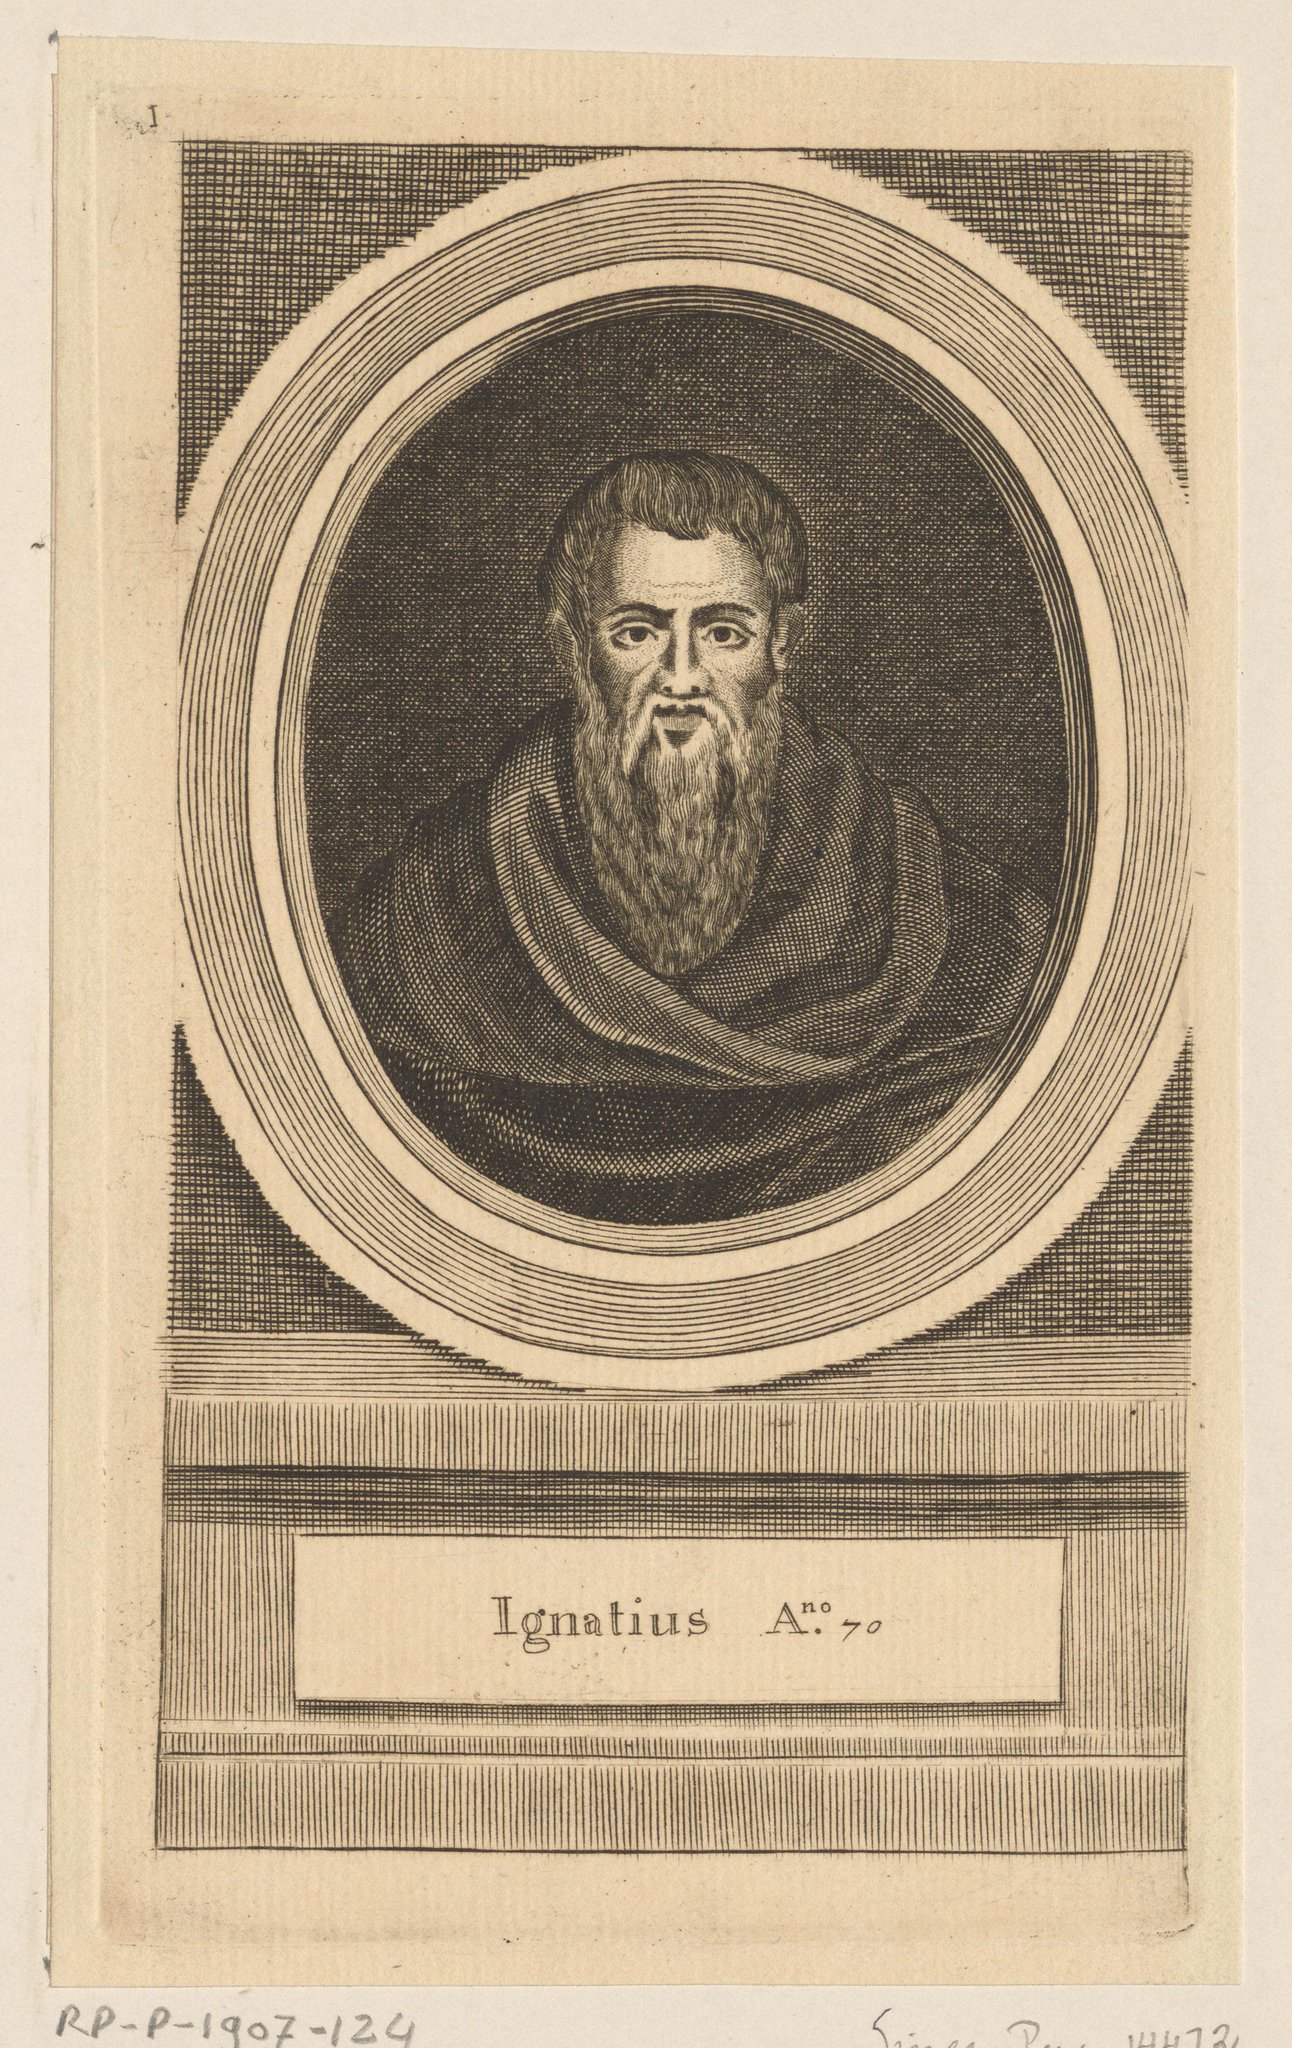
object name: print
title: Portret van Ignatius van Antiochië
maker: Anonymous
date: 1700-1799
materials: paper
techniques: engraving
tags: rome, archbishop, bishop, etc. (roman catholic), historical persons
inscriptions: collector's mark: Lugt 2228